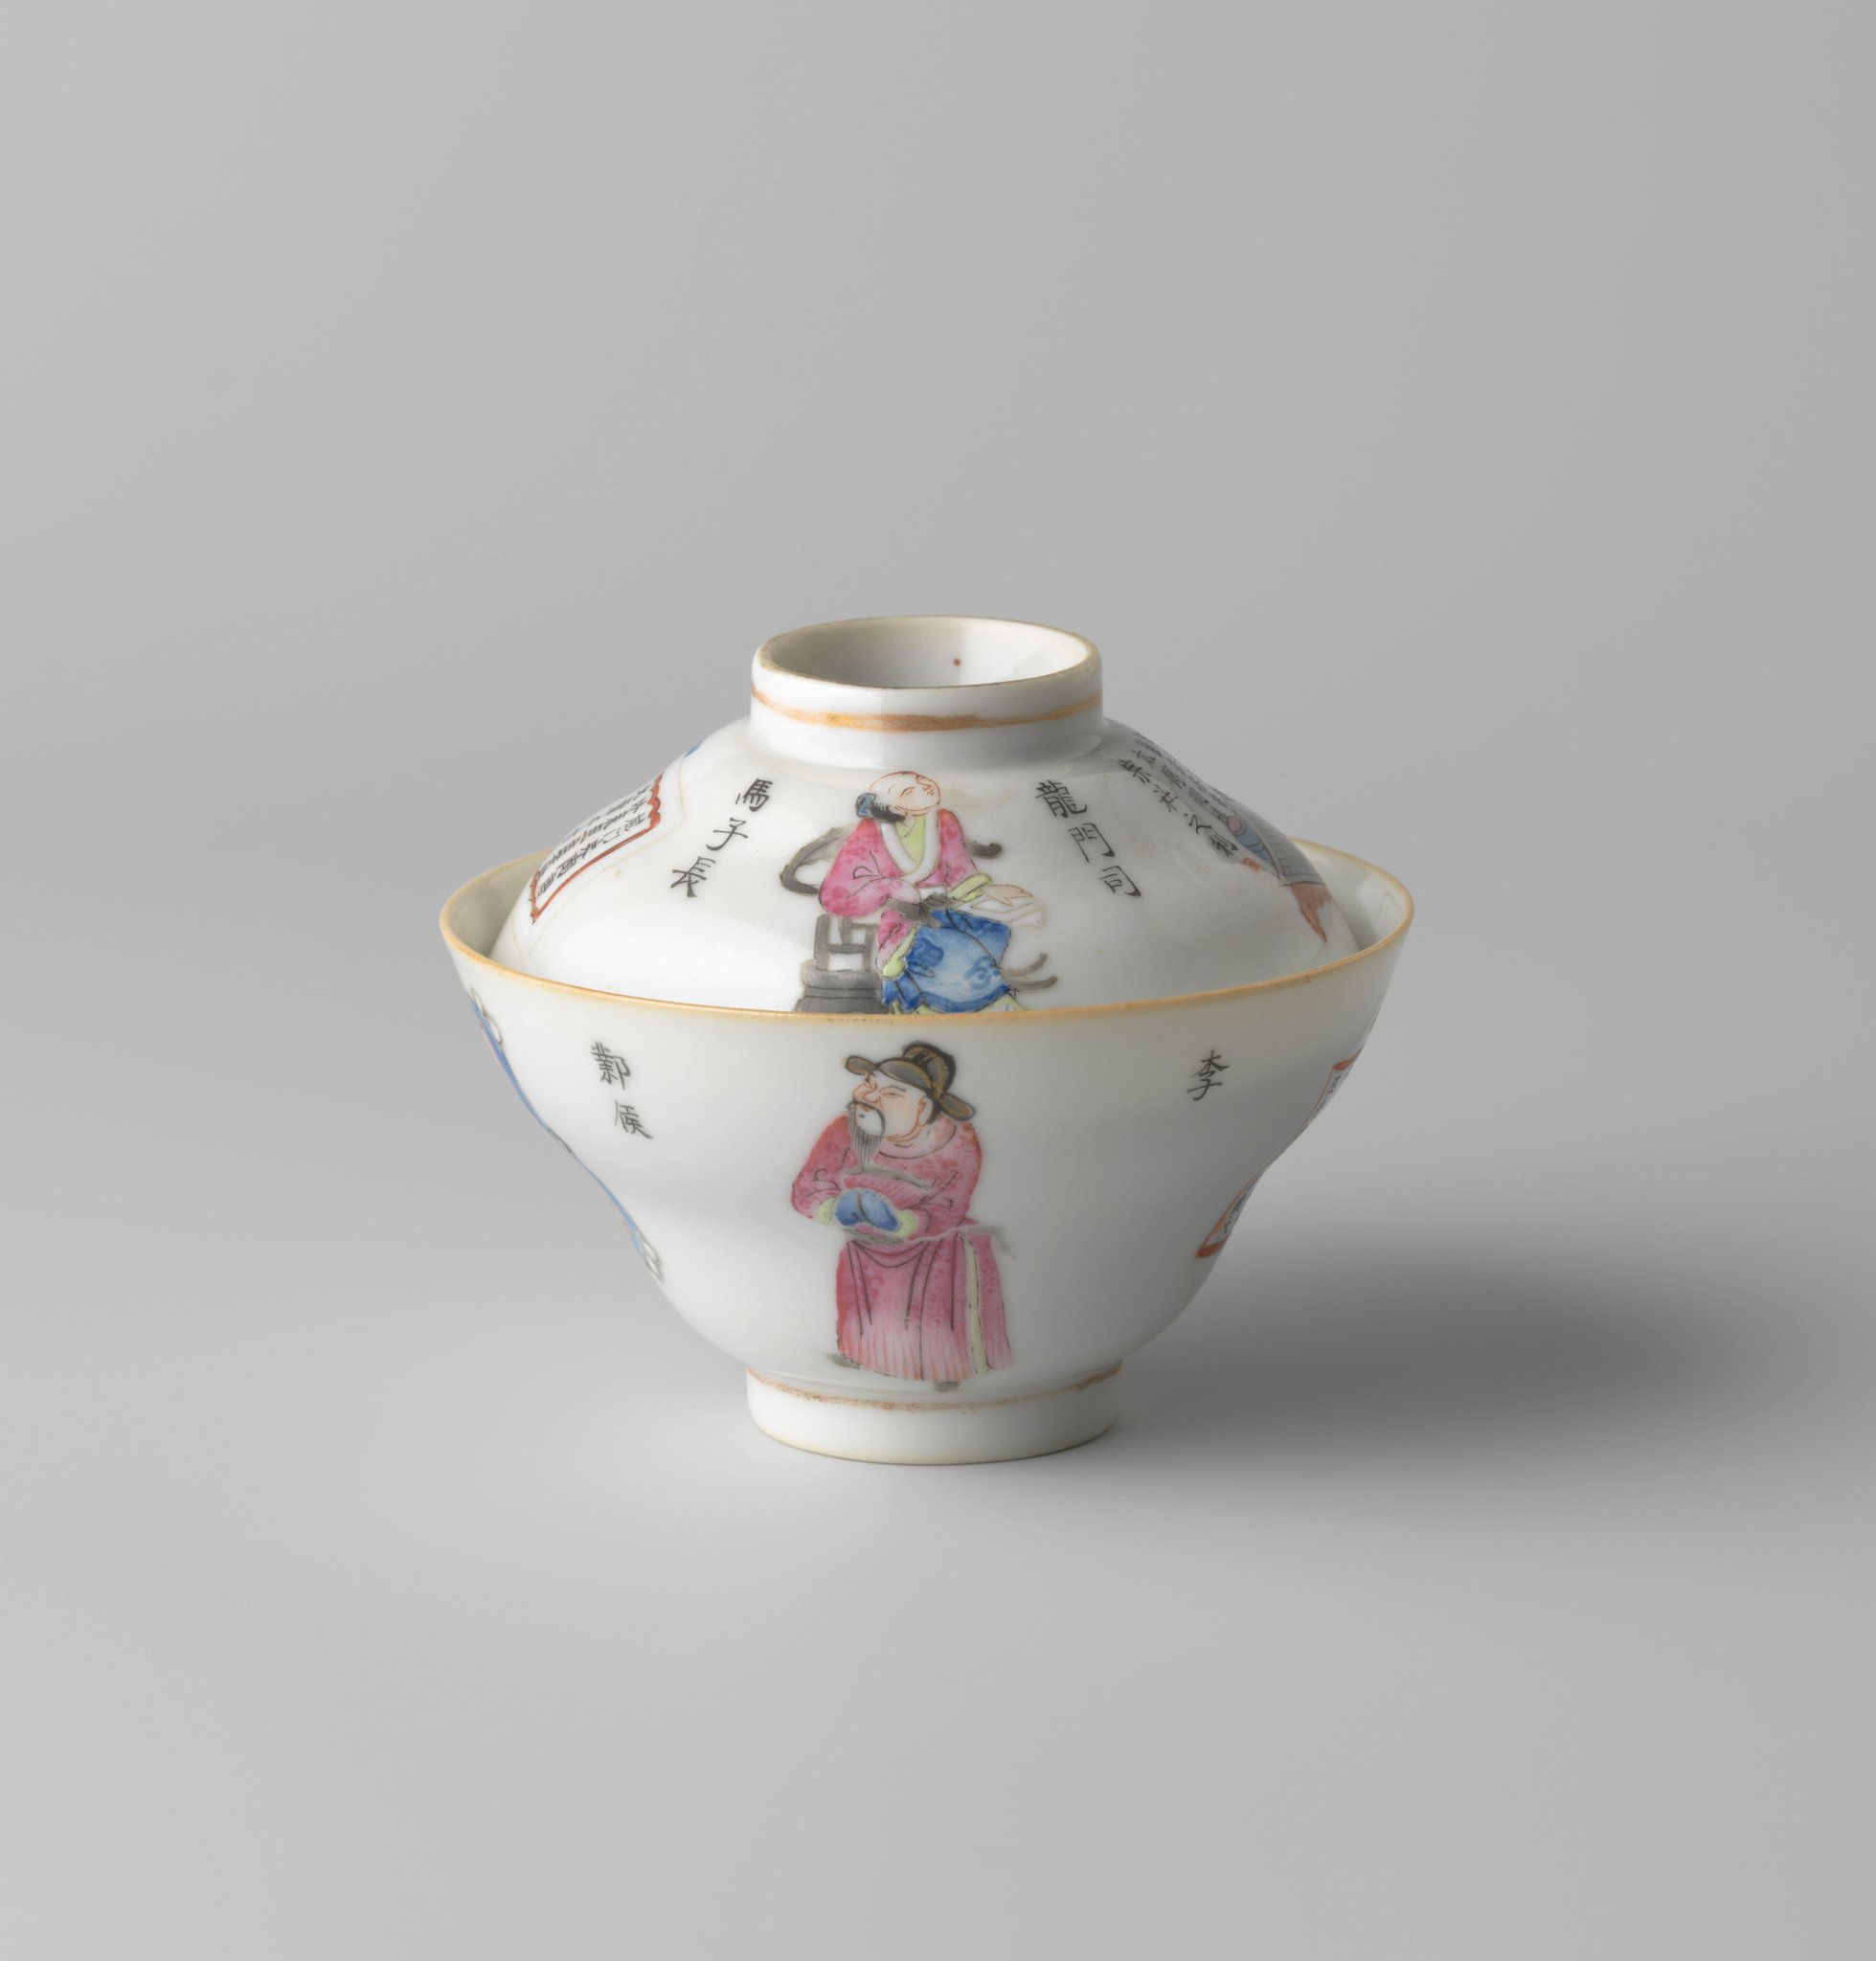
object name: kop en schotel, kop en schotel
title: Covered cup with figures, a go-bord and inscriptions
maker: Anonymous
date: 1800-1899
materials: glaze, gold, paint, porcelain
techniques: firing, gilding, turning, vitrification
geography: china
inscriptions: mark: ‘大 清 道 光 年 製’, mark: ‘大 清 咸 豐 年 製’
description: Deksel van kop van porselein met een getrapte wand, beschilderd op het glazuur in blauw, rood, roze, groen, geel, zwart en goud. De deksel met dezelfde soort decoratie als de schotel, met twee andere personen, één cartouche en een go-bord. De deksel gemerkt met het zegelmerk van keizer Daoguang (?). Famille rose.